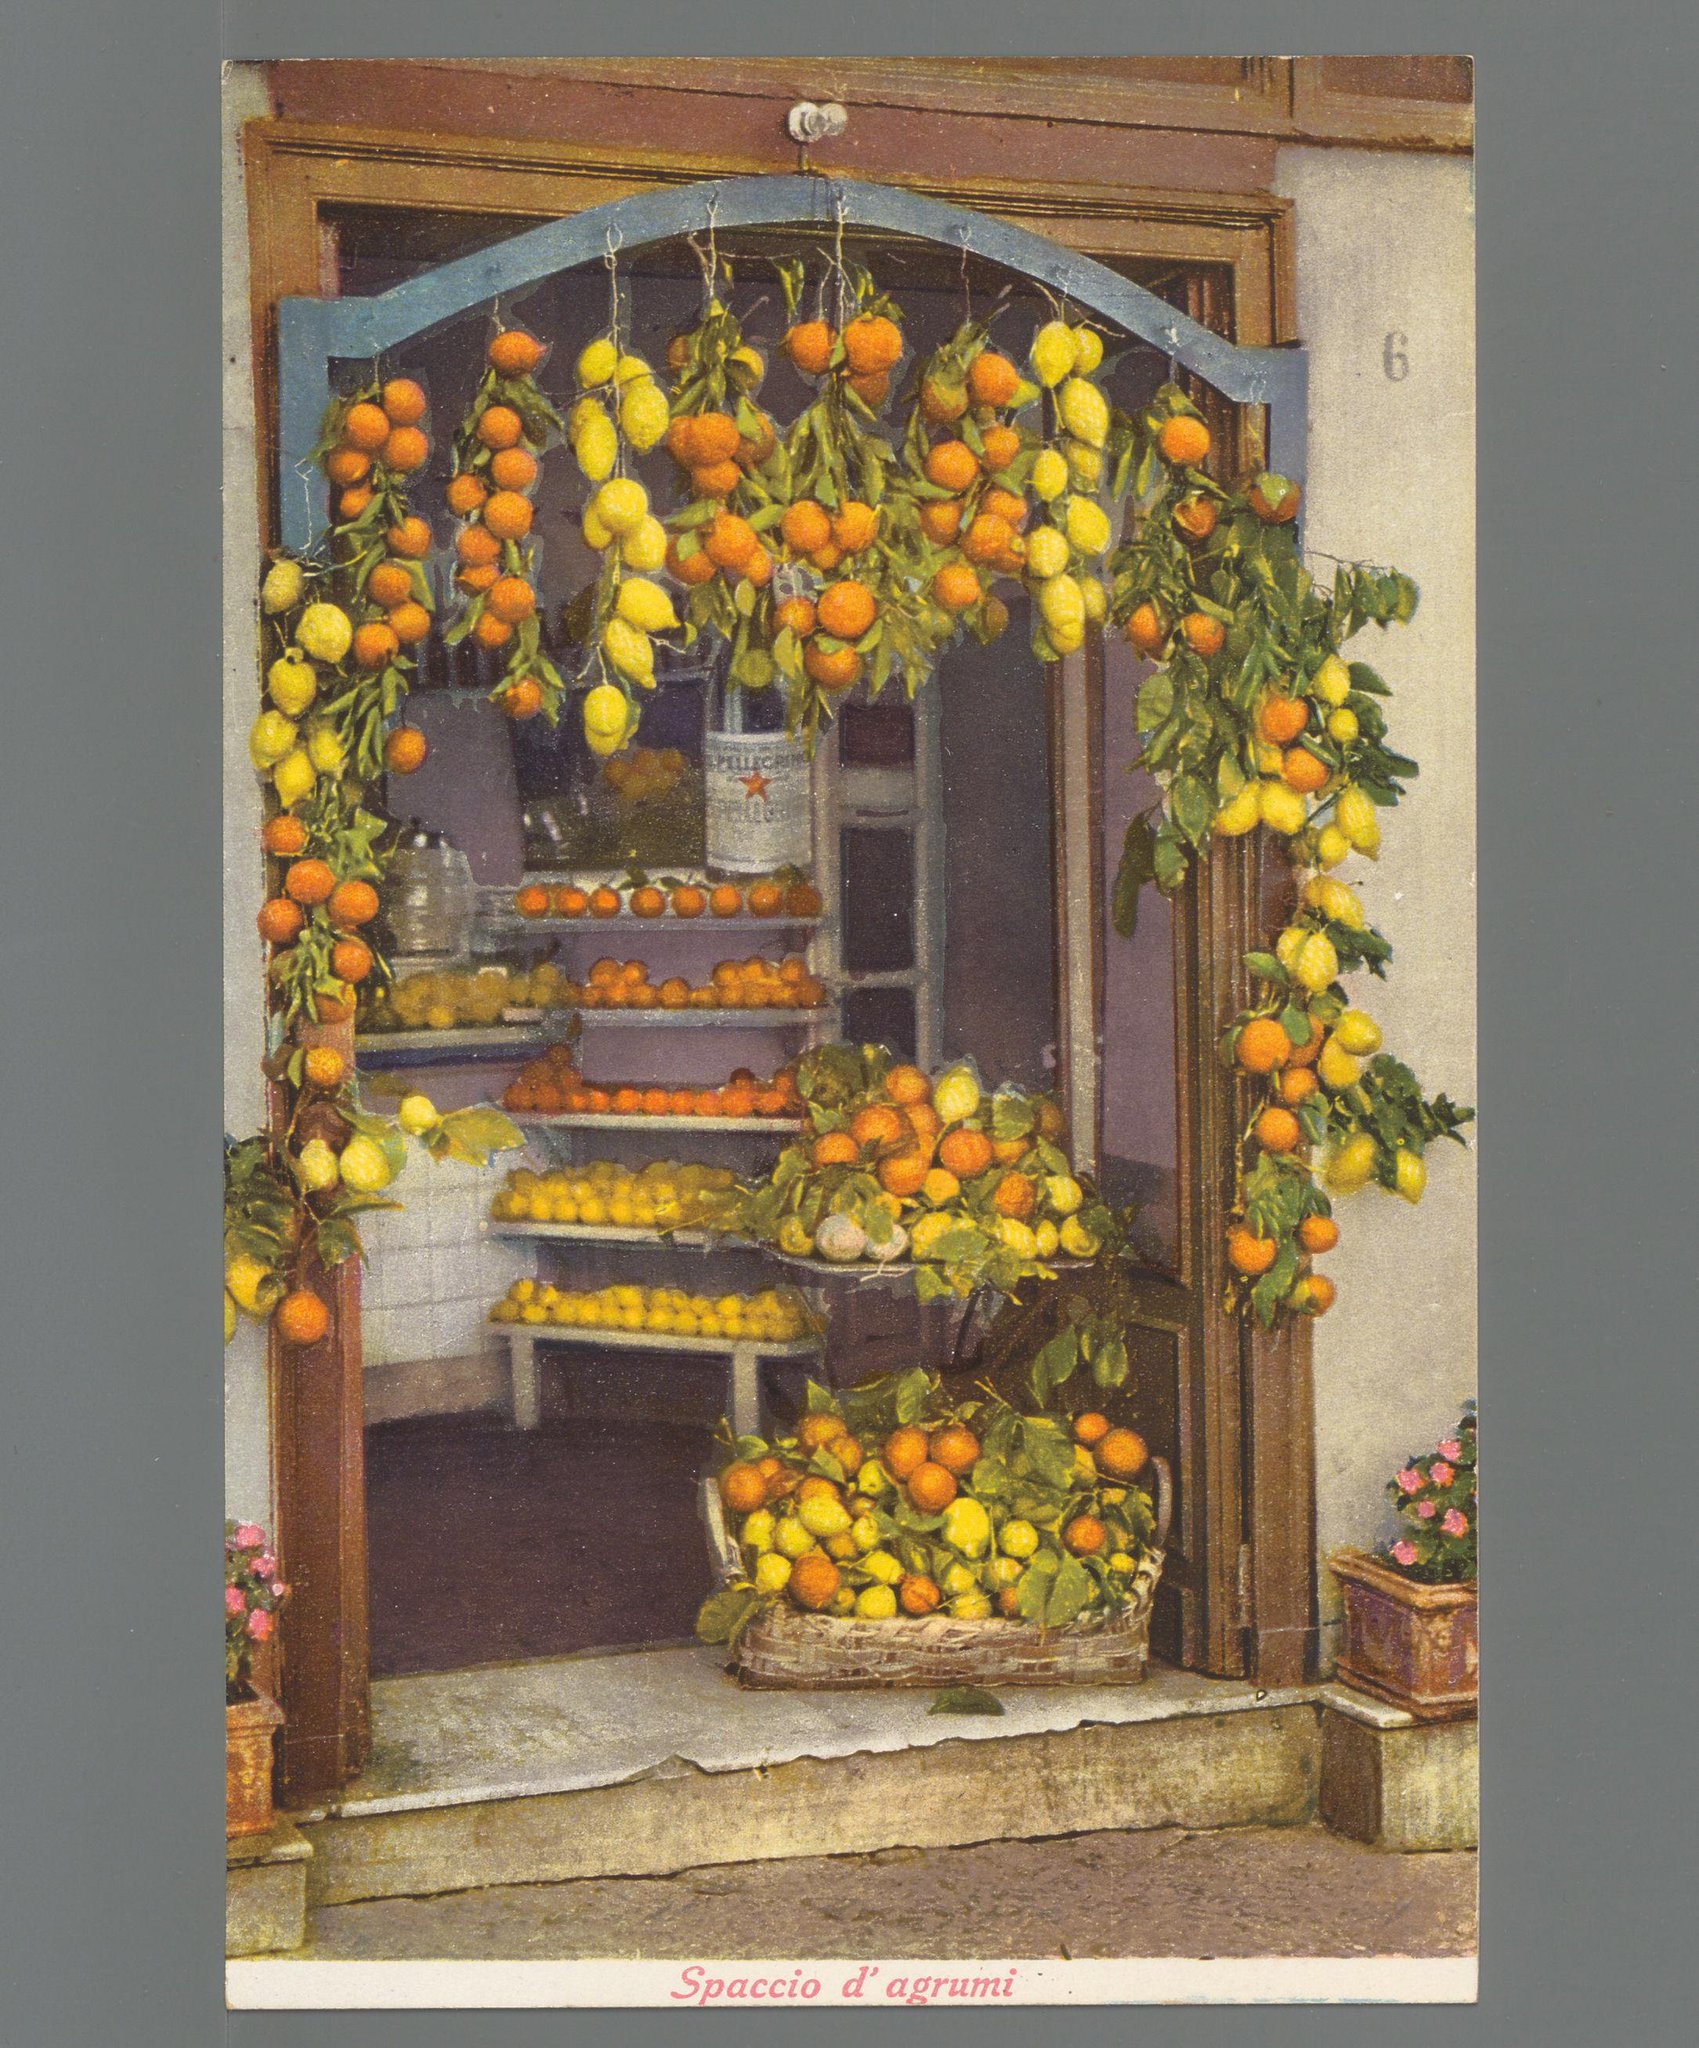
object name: ansichtkaart, prentbriefkaart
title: Spaccio d'agrumi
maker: Anonymous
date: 1906-1930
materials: cardboard, photographic process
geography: zurich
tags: shop, store, fruit, italy